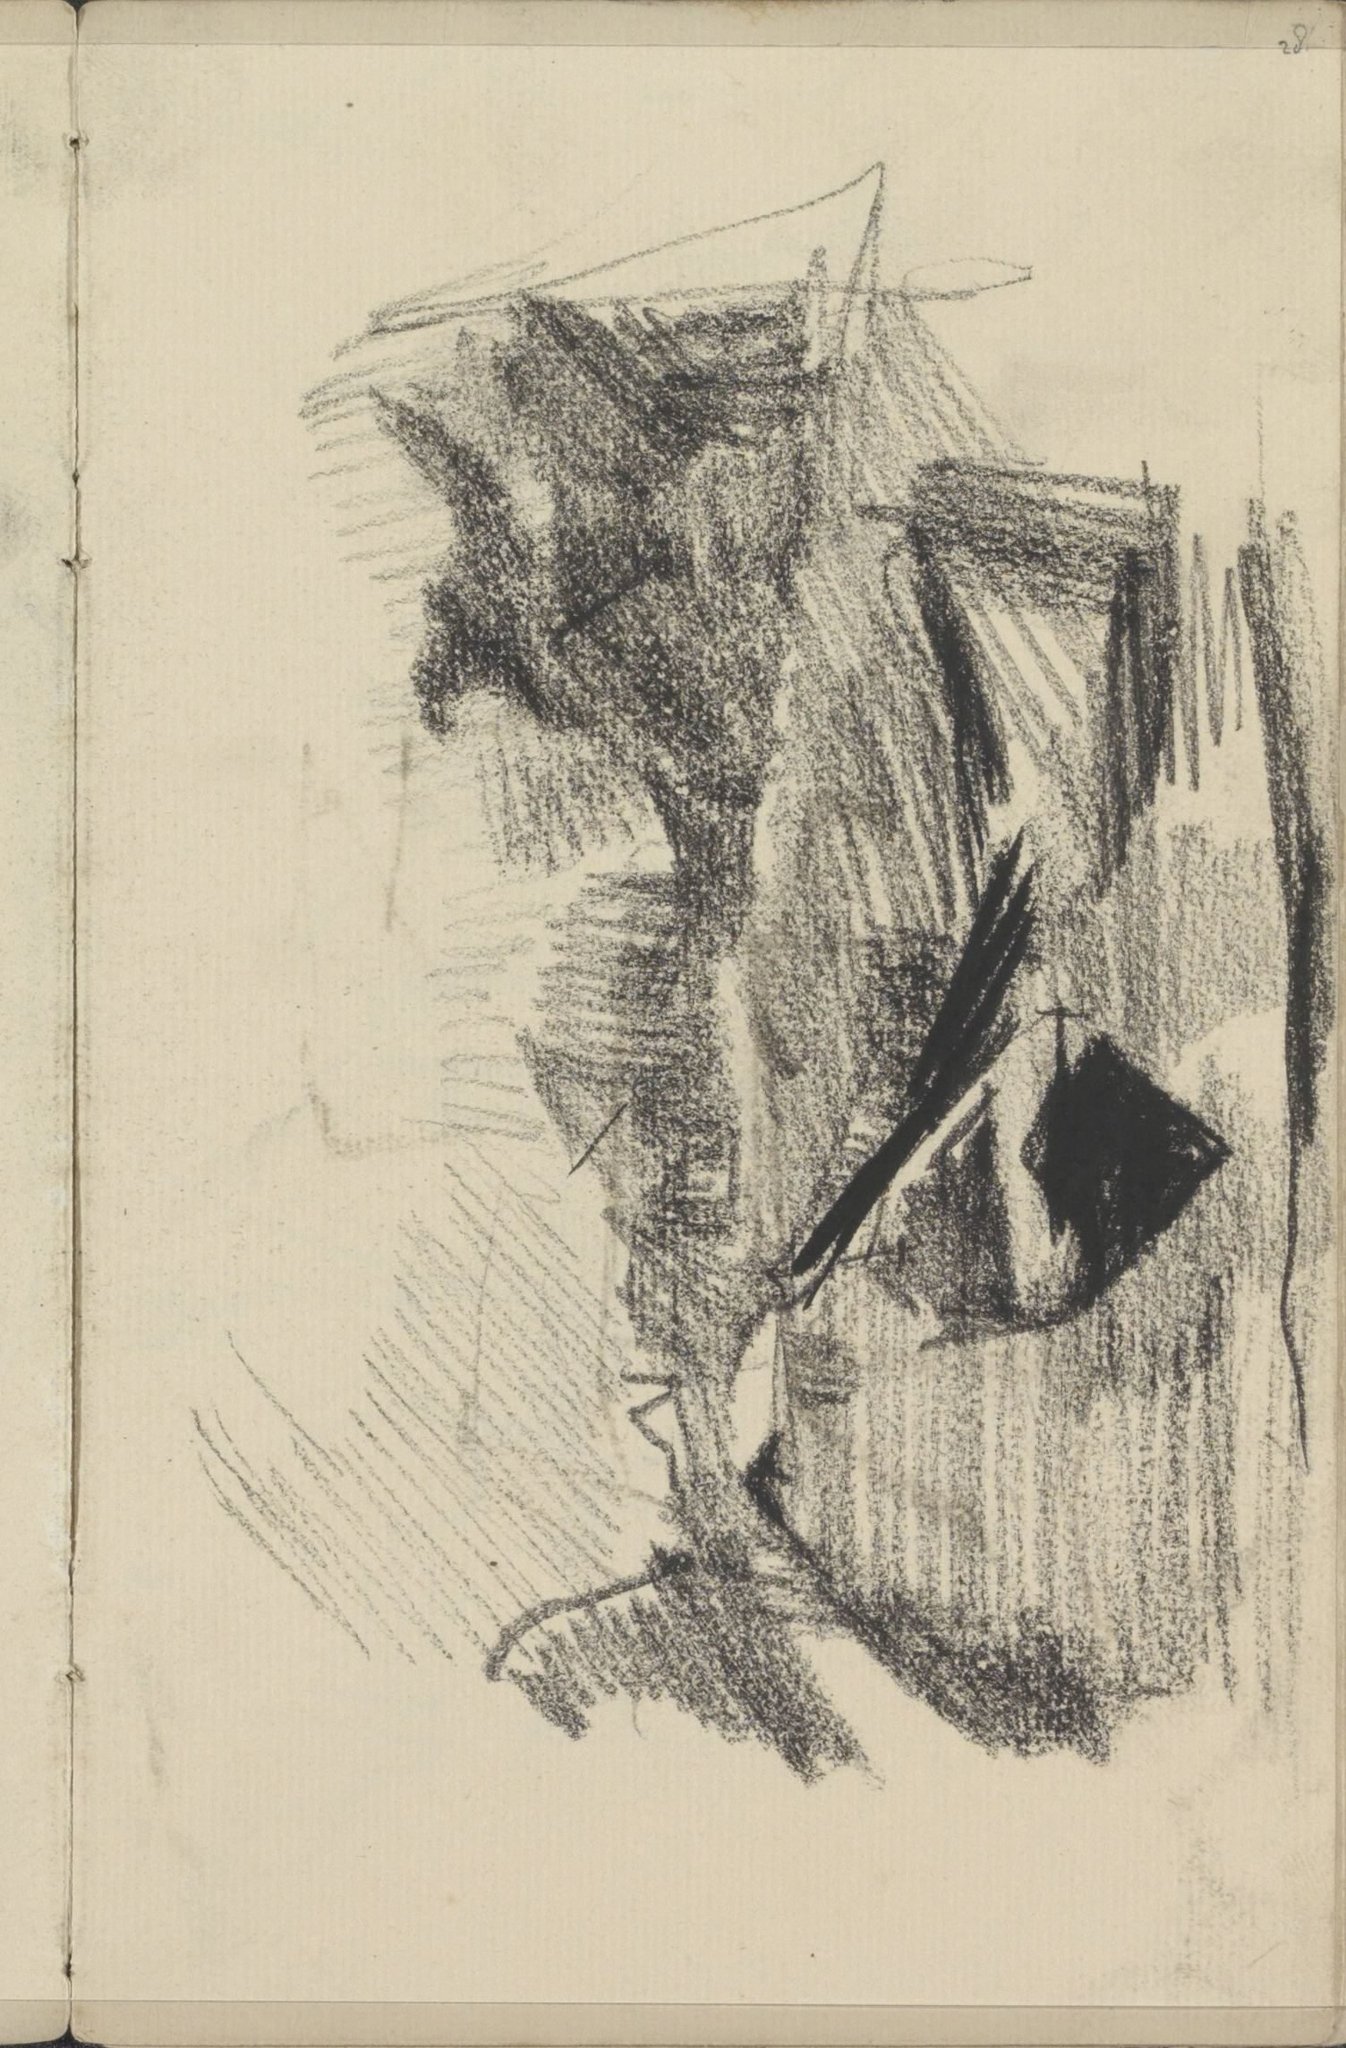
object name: sketchbook leaf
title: Landschap met een boot in het water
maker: george hendrik breitner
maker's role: draughtsman, painter, print maker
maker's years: 1857-1923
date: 1883-1884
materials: chalk, paper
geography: the hague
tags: rowing-boat, canoe, etc., small canal, ditch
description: Pagina 28 uit een schetsboek met 23 bladen.